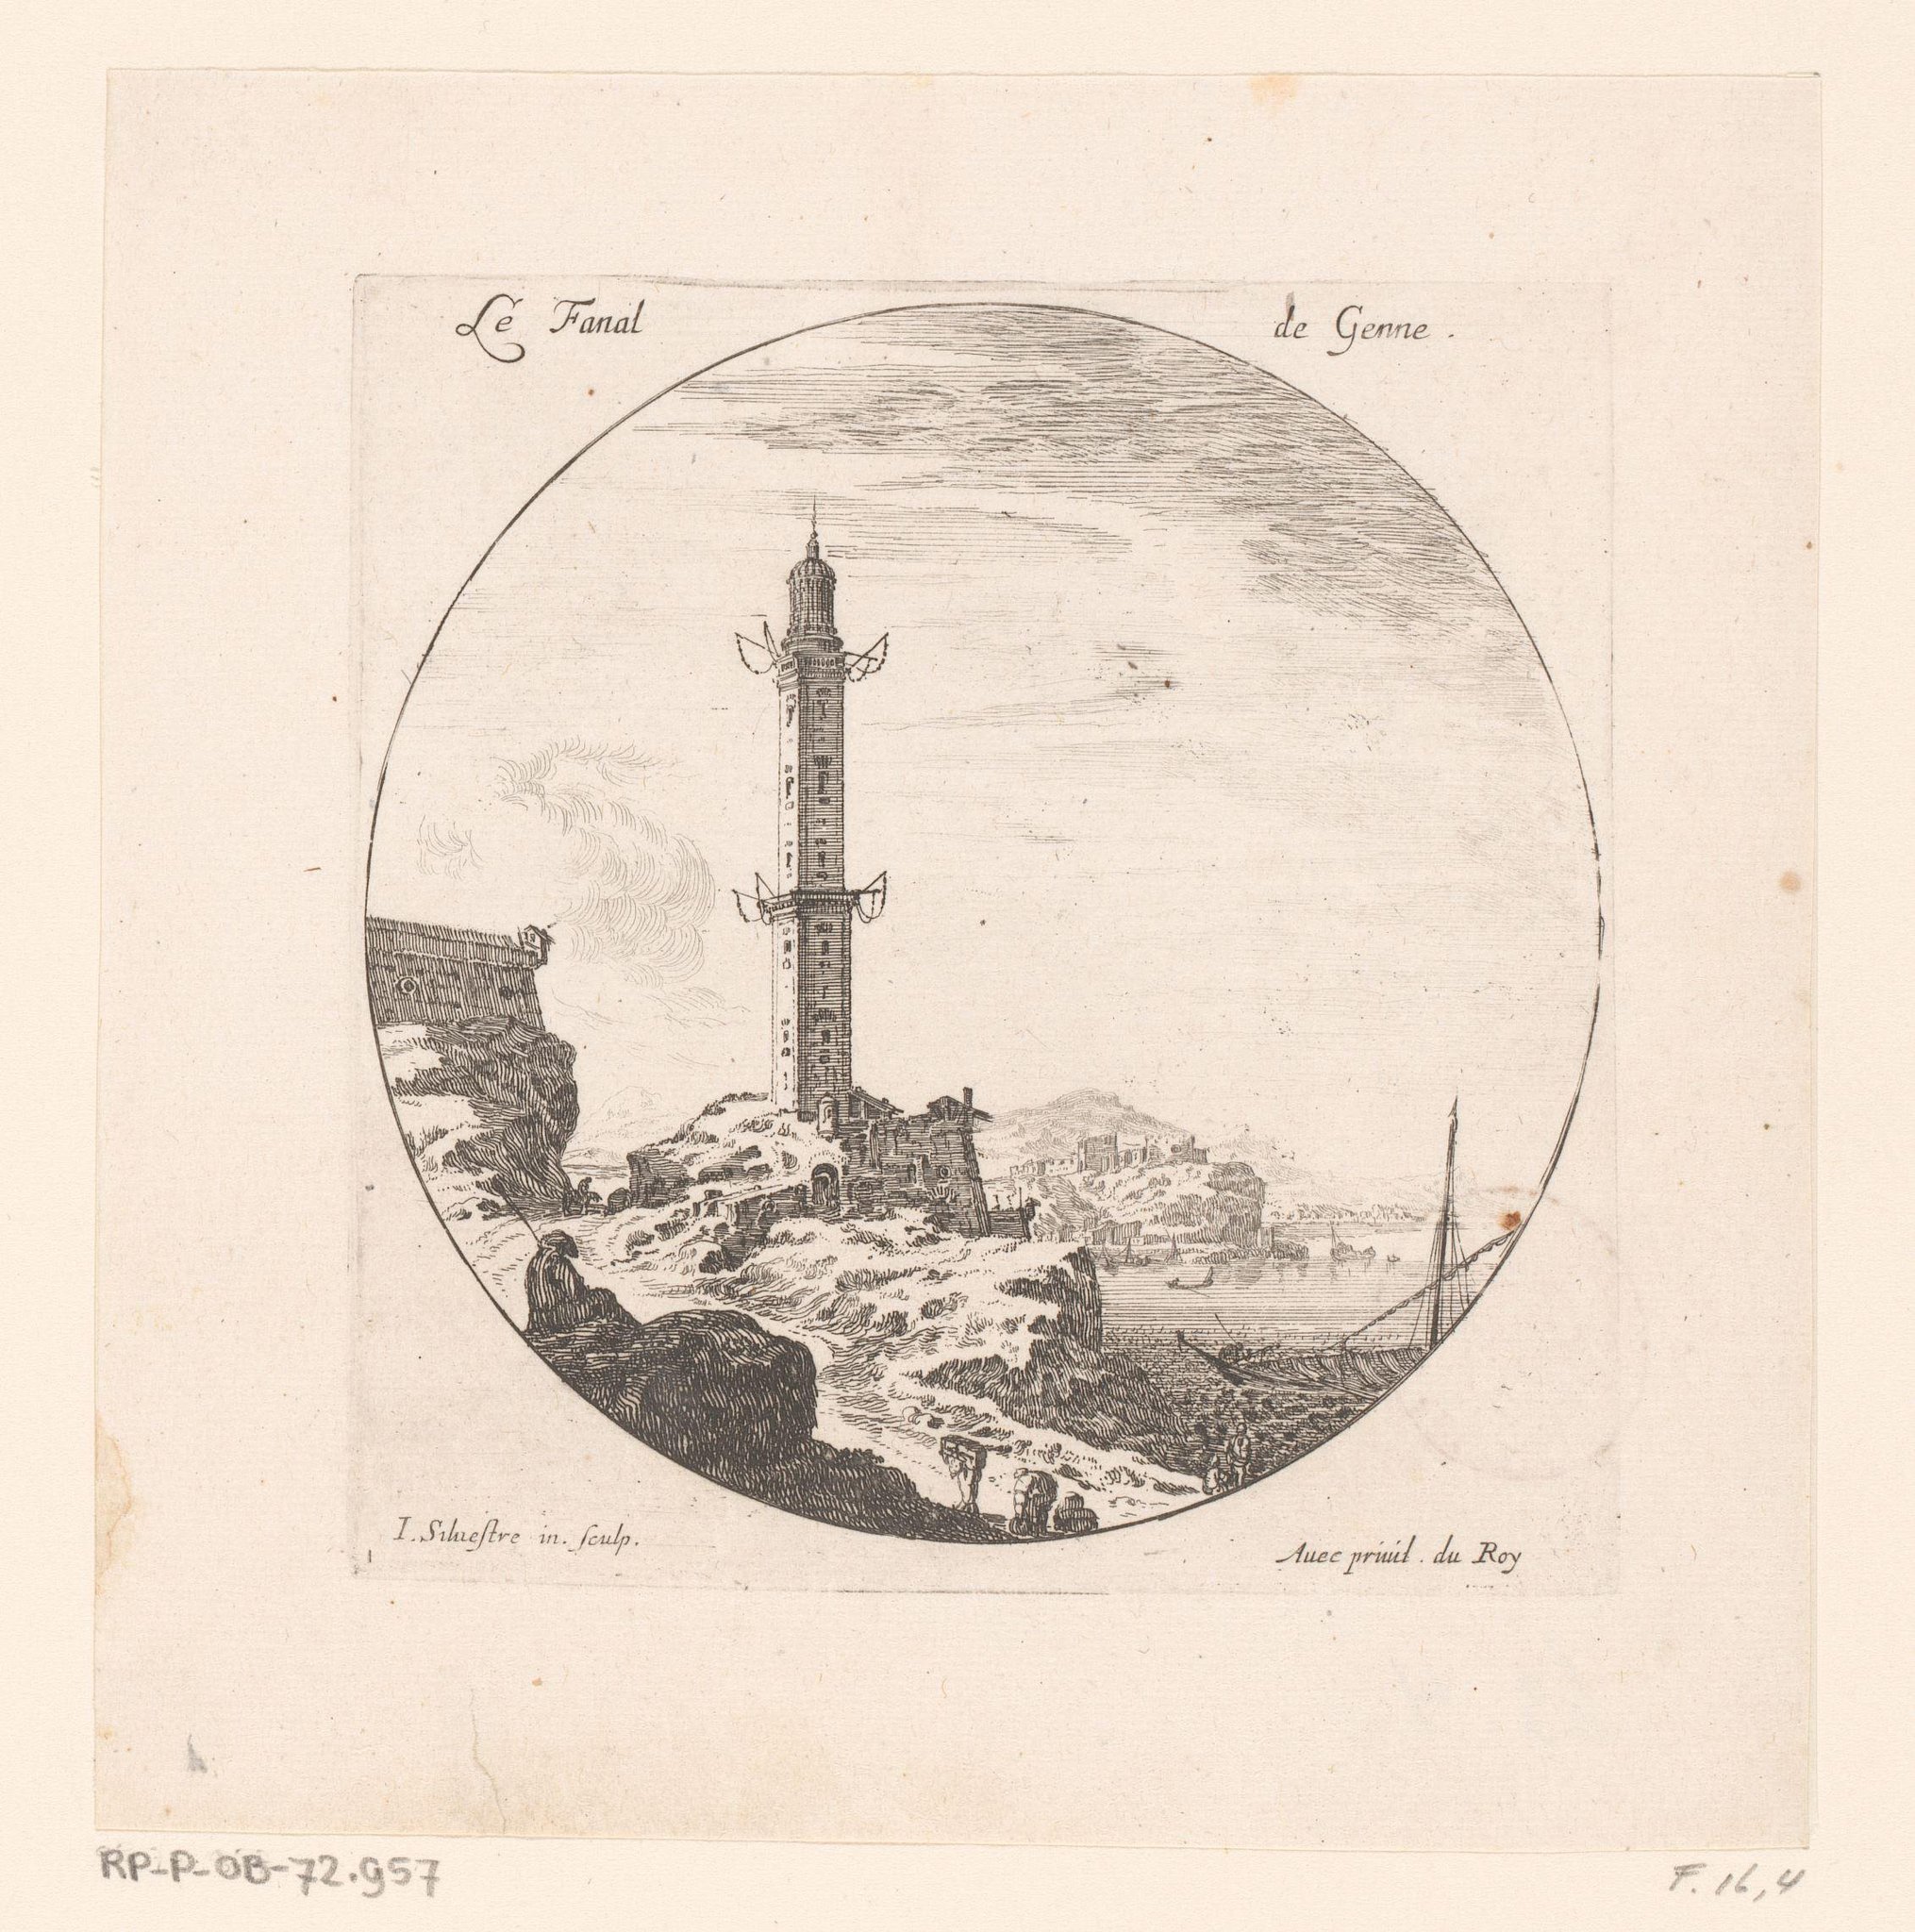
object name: print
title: Diverse gezichten op zeehavens in Italië en andere plaatsen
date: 1631-1657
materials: paper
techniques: etching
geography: france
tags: harbour, lighthouse, lightship, city-view in general; 'veduta'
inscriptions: collector's mark: Lugt 240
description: Prent maakt deel uit van een ongenummerde serie van zes prenten.